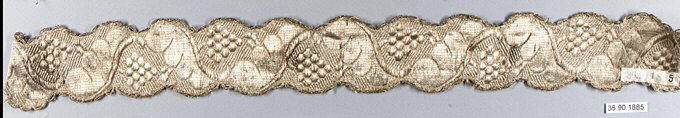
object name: galloon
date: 1767-1833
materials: metal thread